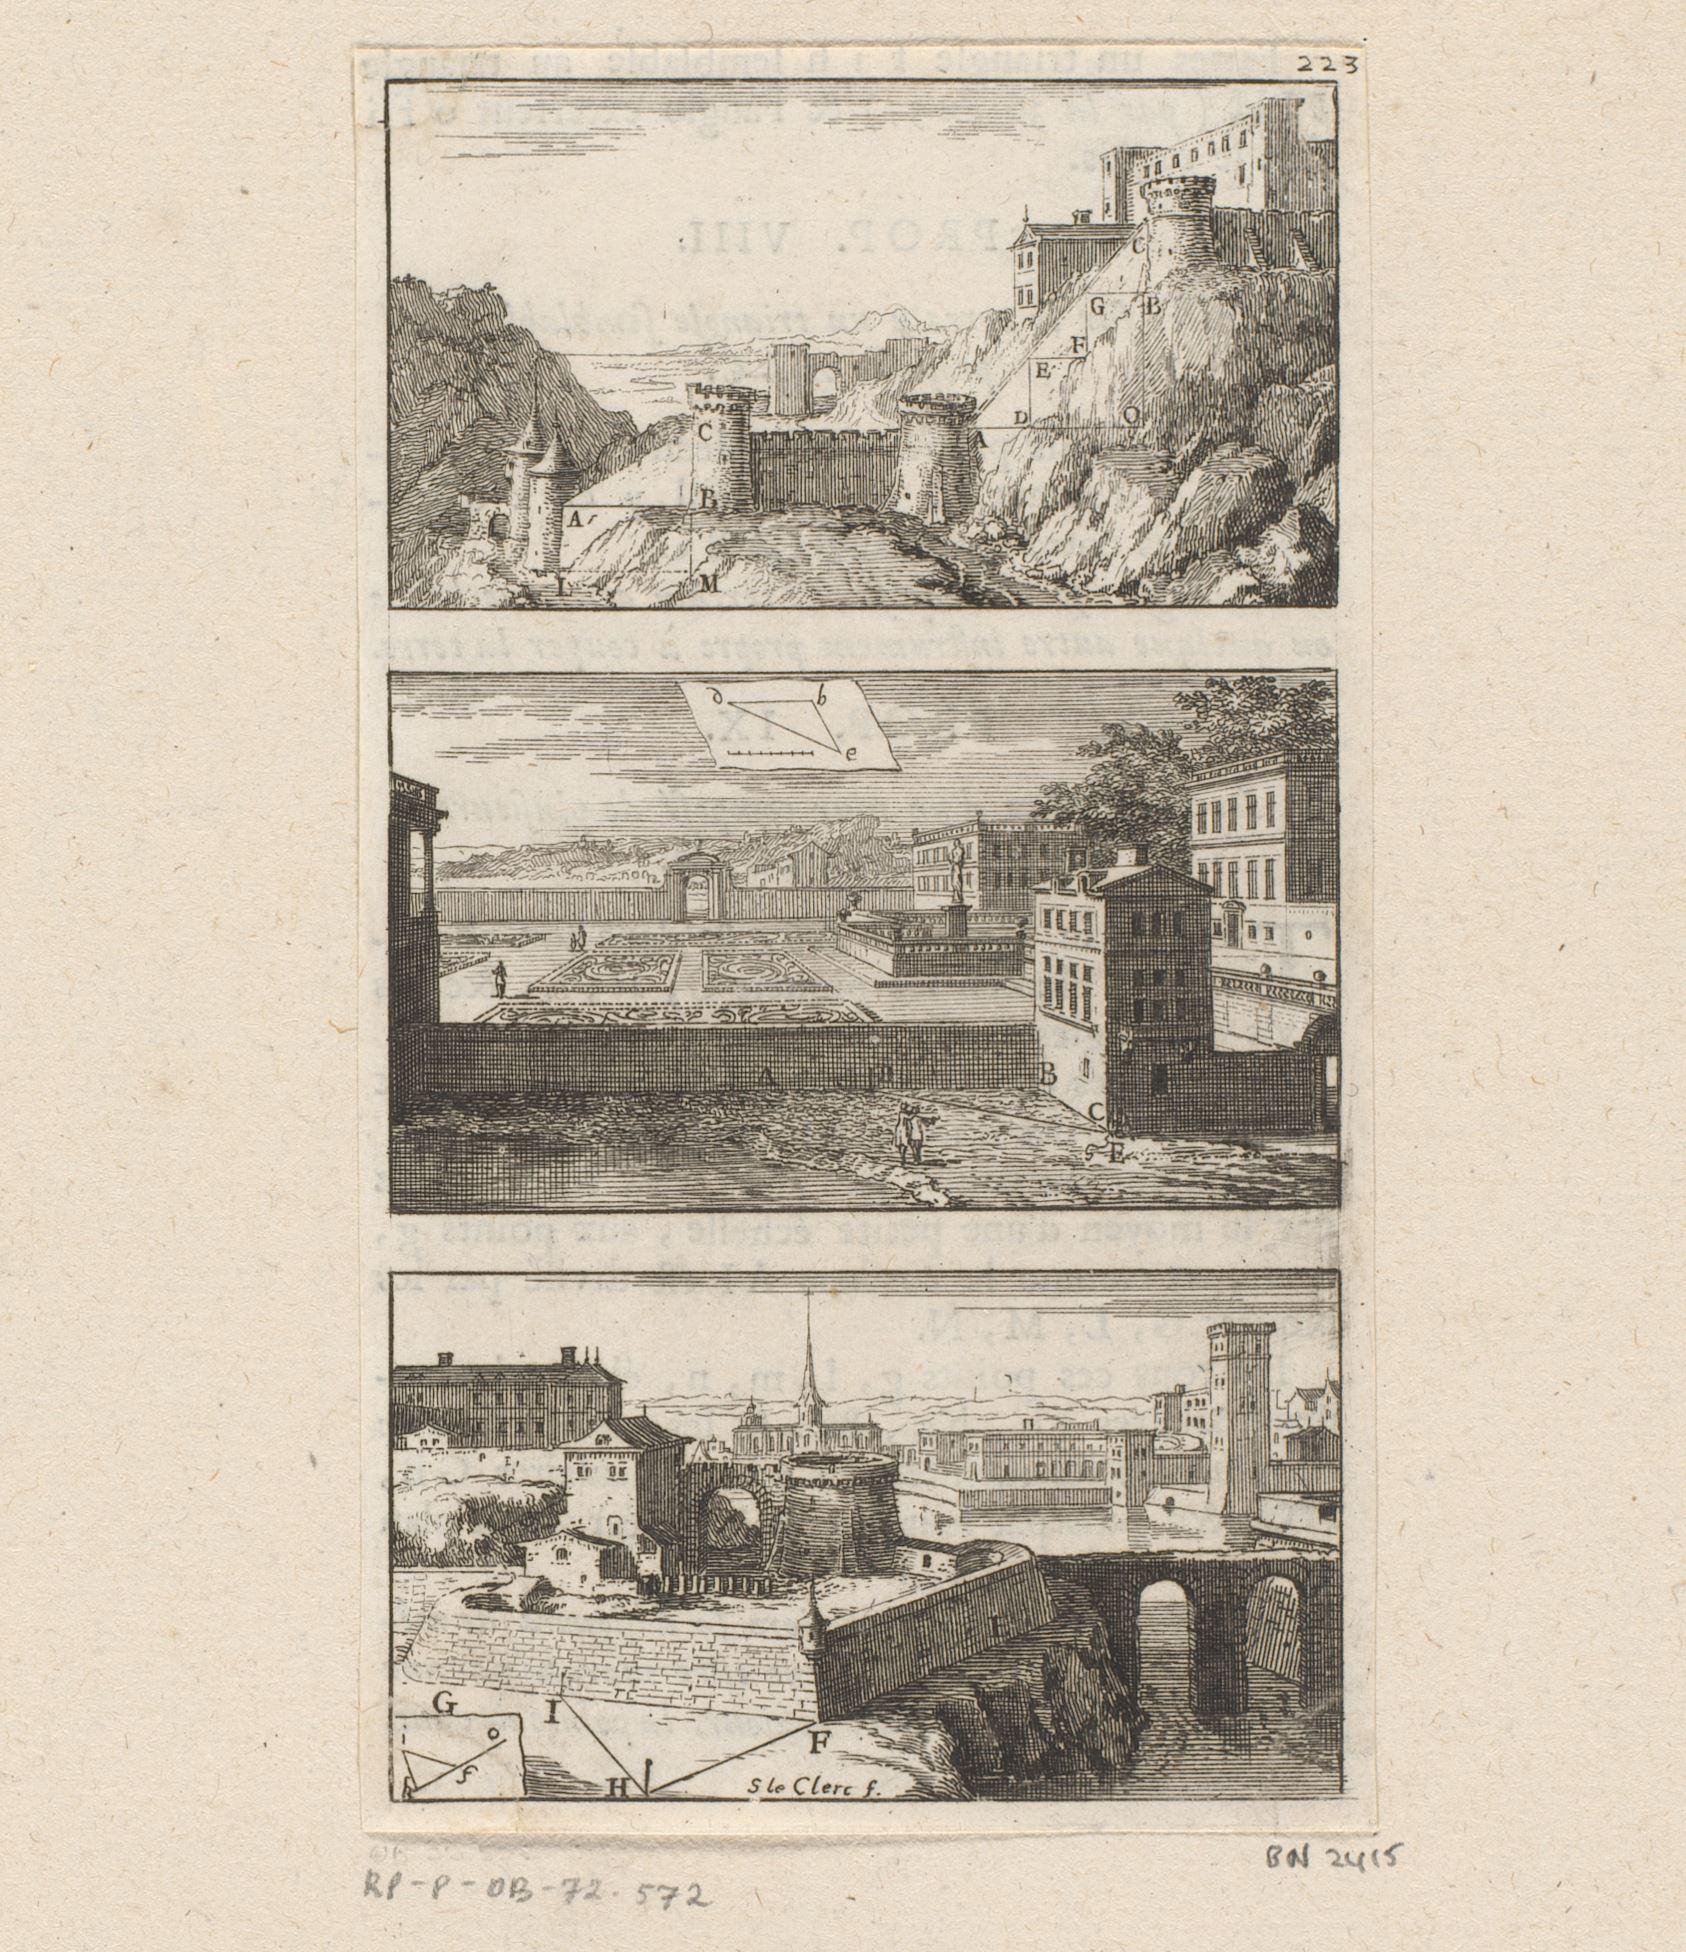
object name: print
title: Gebruik van het meetlint geïllustreerd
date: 1690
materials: paper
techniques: etching, letterpress printing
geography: france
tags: fortress, city-view in general; 'veduta', palace, planimetry, geometry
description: Prent uit: Leclerc, Sébastien. Traité de géométrie (...). Parijs: Jean Jombert, 1690.